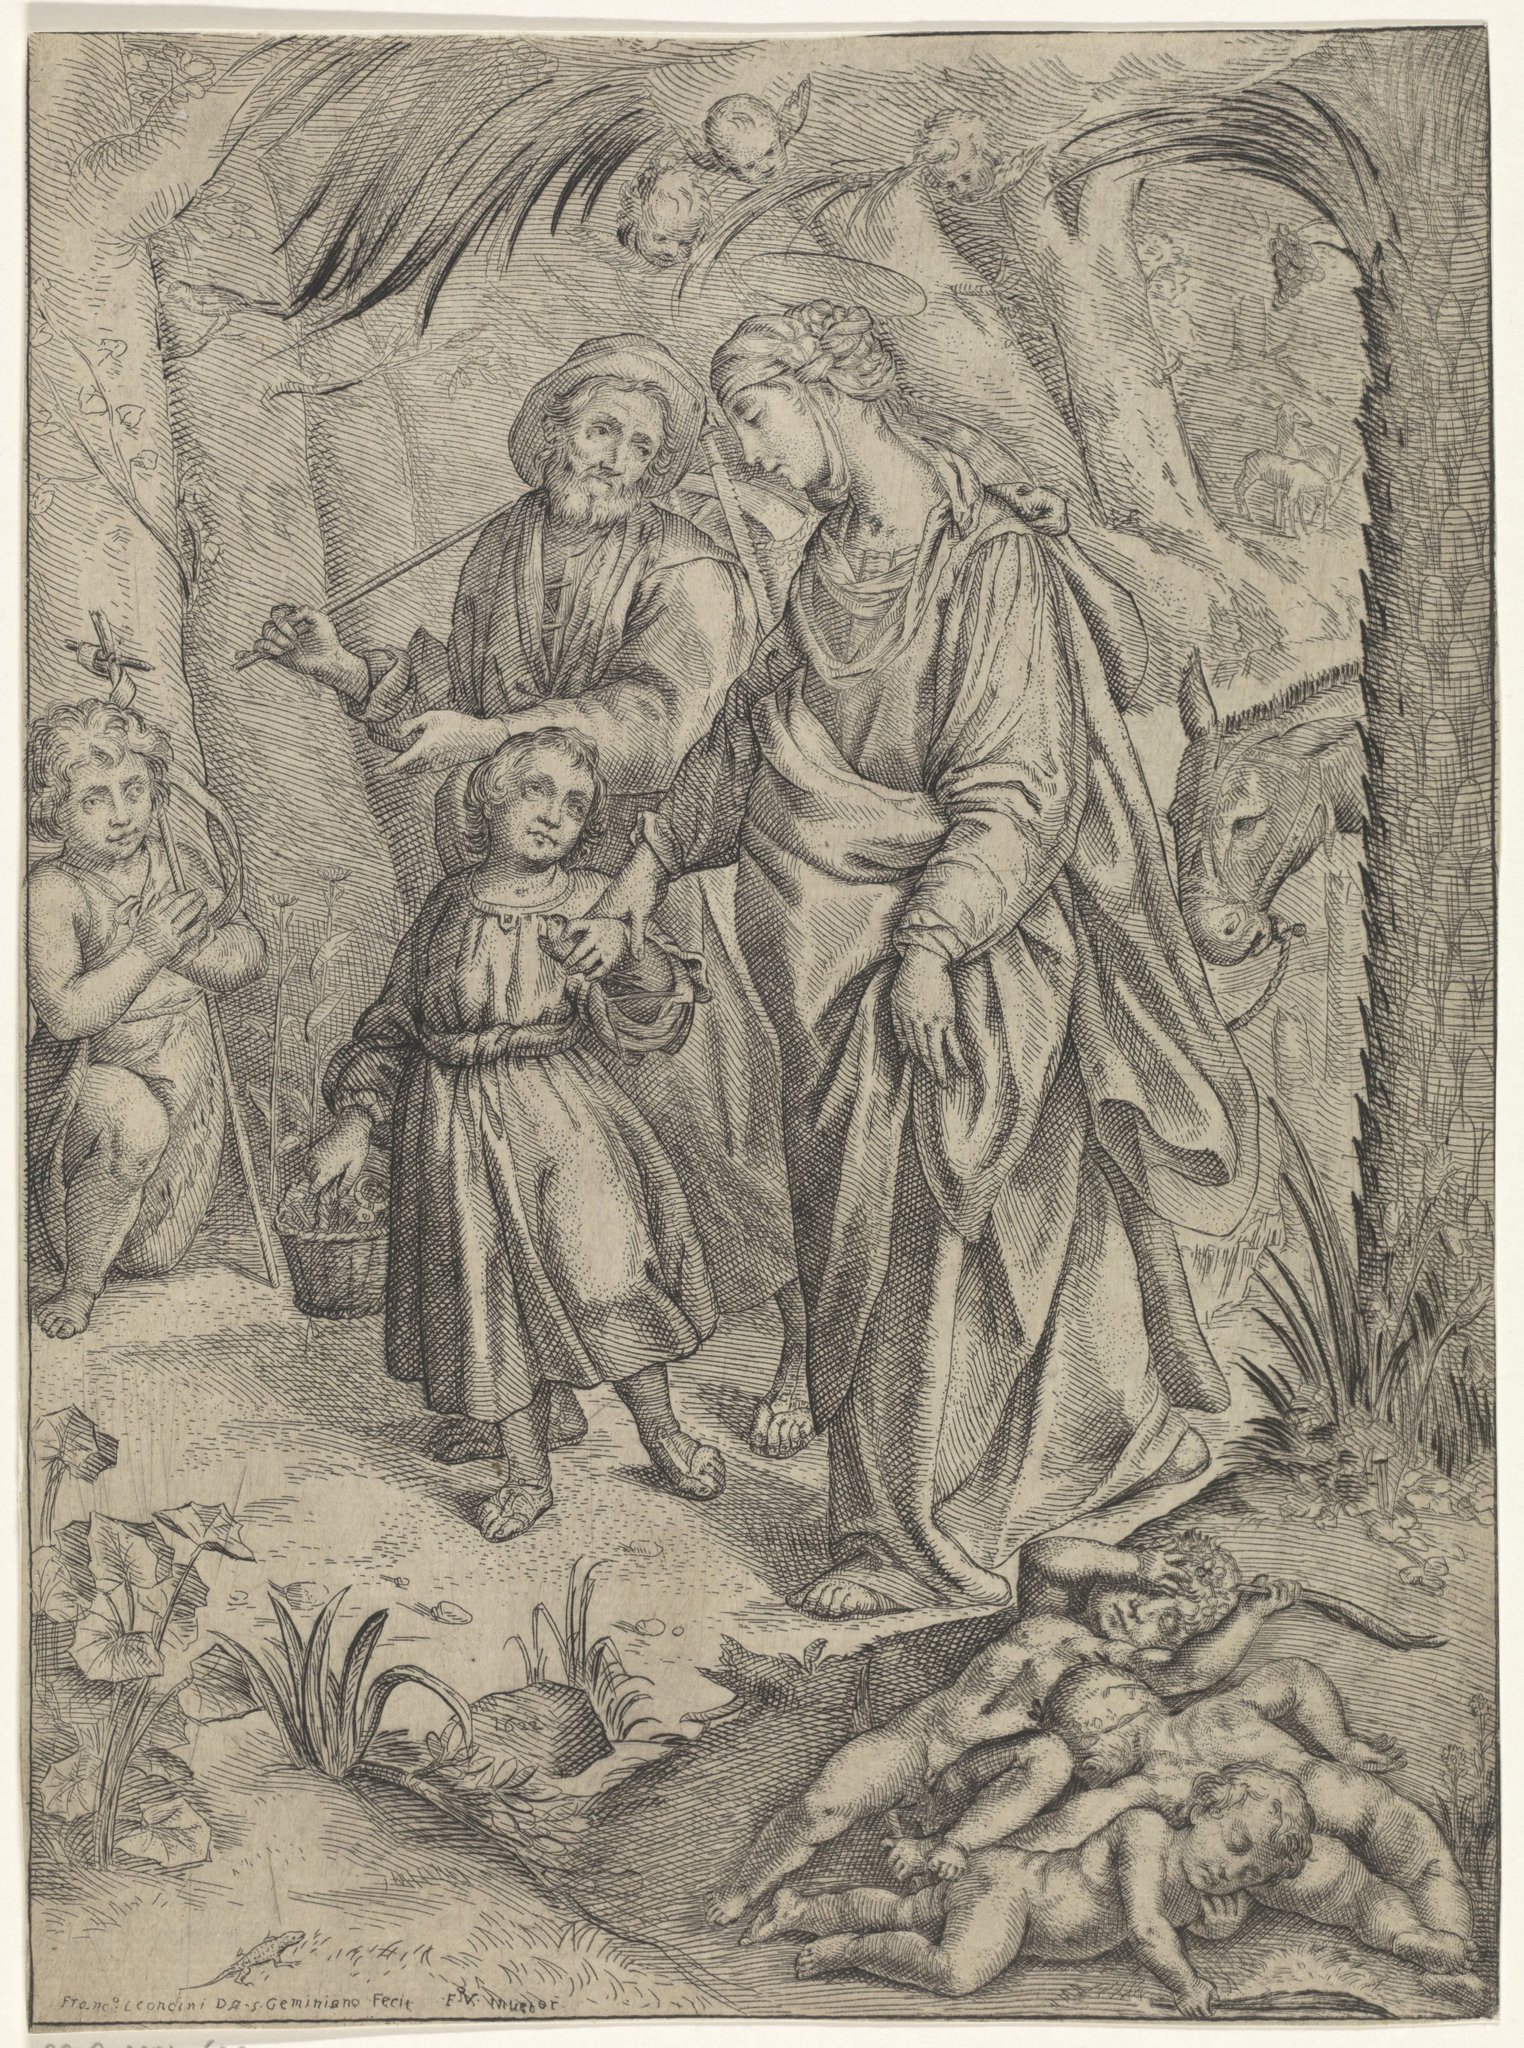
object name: print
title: Terugkeer van de vlucht naar Egypte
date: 1623-1666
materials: paper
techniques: etching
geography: italy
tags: holy family with john the baptist (as child), cupids: 'amores', 'amoretti', 'putti', the holy family (and sometimes others) returning to israel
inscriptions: collector's mark: Lugt 2760, collector's mark: Lugt 2228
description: De terugkeer van de Heilige Familie uit Egypte. Maria en Jozef lopen met het Christuskind tussen hen in op een weggetje. Ze lopen onder een palmboom waar cherubijnen tussen de bladeren zweven. Links de knielende jonge Johannes de Doper. Op de voorgrond rechts liggen drie kinderen die gestorven zijn tijdens de Kindermoord te Betlehem.